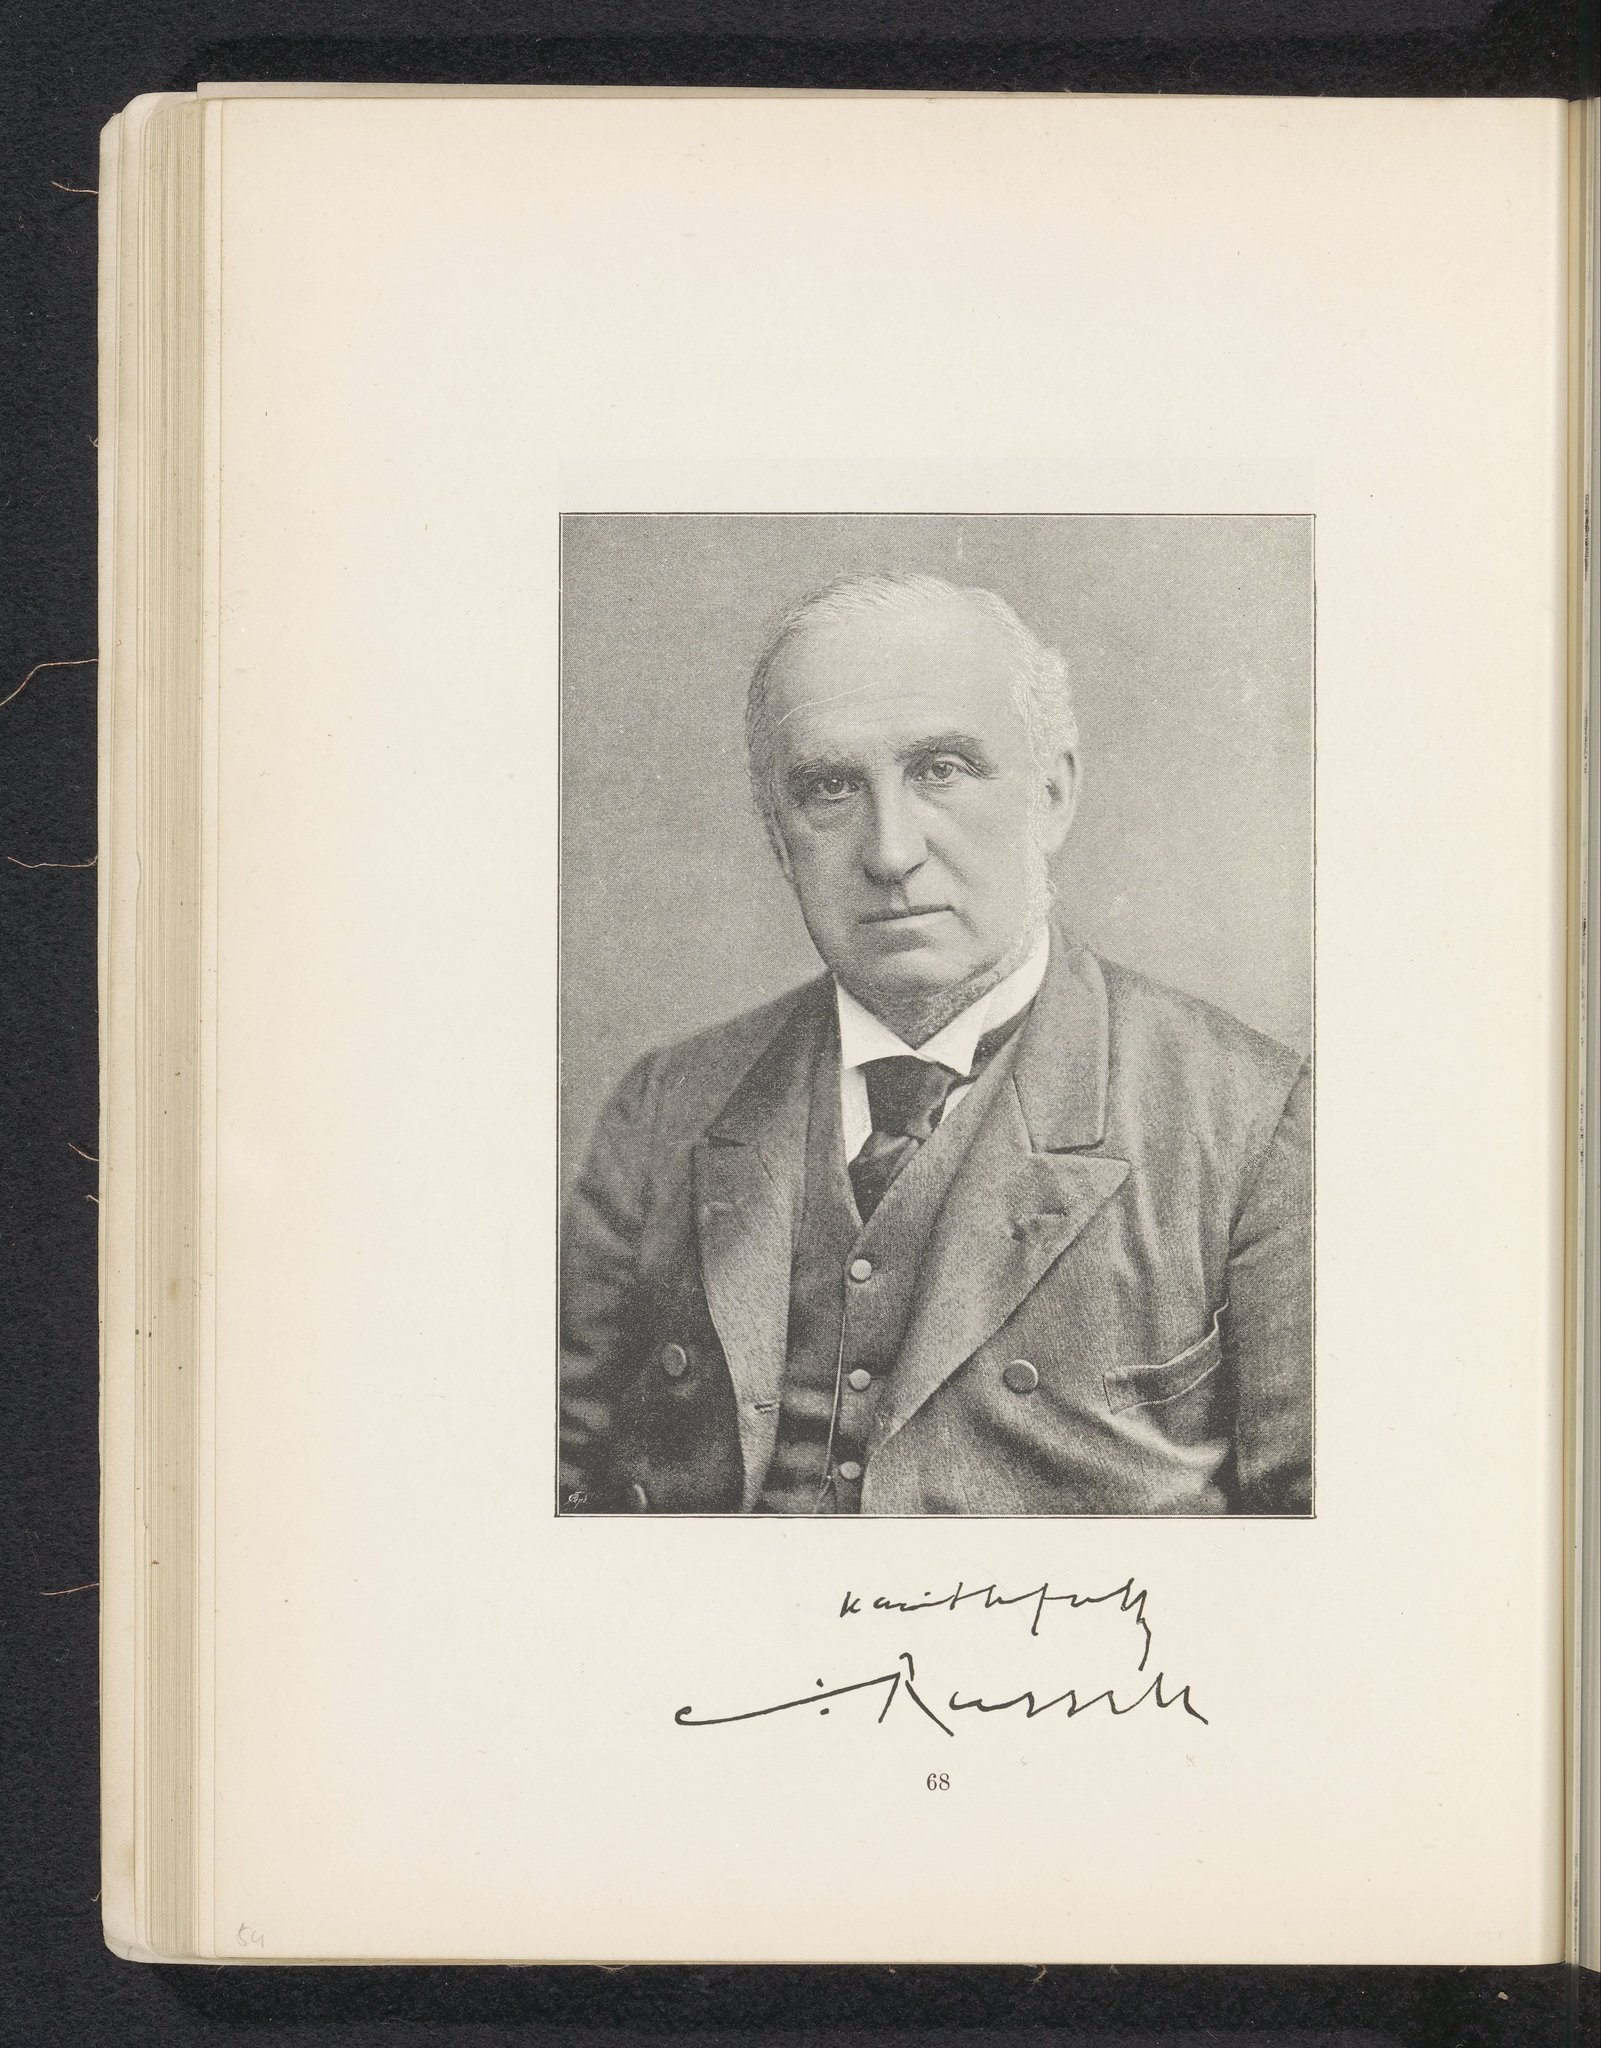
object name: photomechanical print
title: Portret van Charles Russell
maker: Anonymous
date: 1881-1891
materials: paper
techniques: autotype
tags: magistracy, judges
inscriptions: inscription